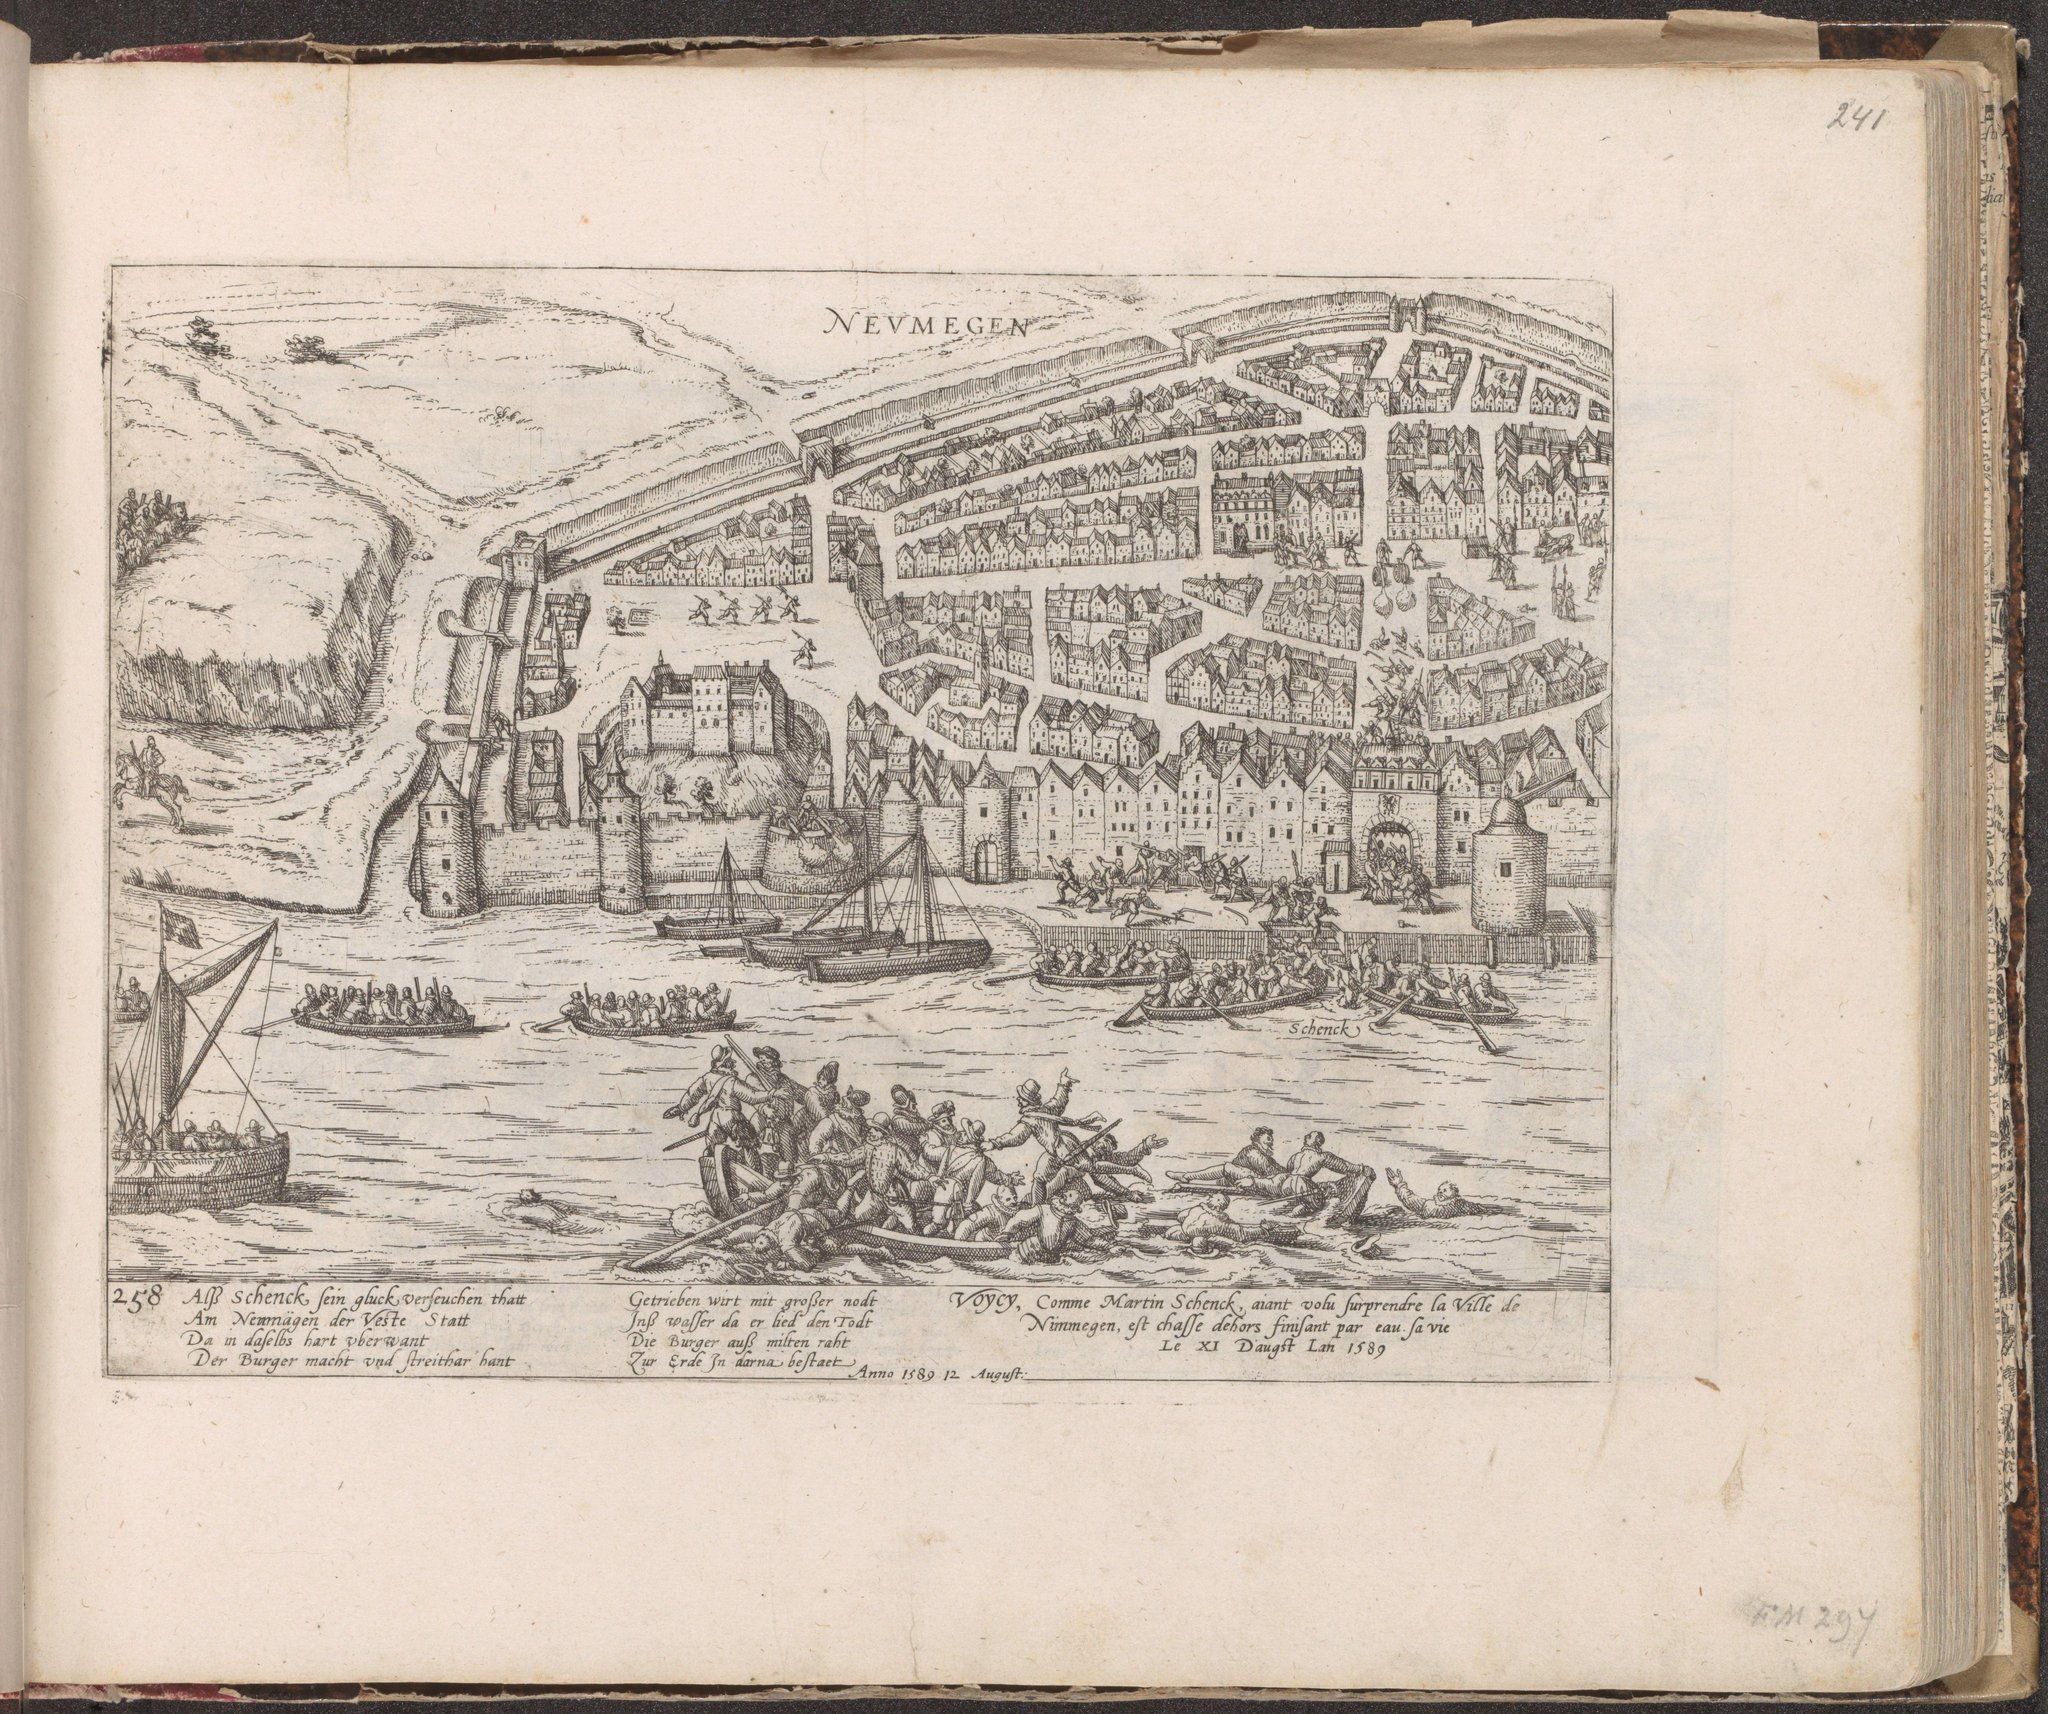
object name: print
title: Serie 10: Nederlandse en Buitenlandse Gebeurtenissen, 1587-1612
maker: frans hogenberg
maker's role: print maker, publisher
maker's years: 1538-1590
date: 1589-1591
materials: paper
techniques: etching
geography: cologne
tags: nijmegen, drowning, shipwrecked person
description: Mislukte aanval op Nijmegen, 10 augustus 1589. Martin Schenck verdrinkt in de Waal. Episode uit de Keulse Oorlog. Met onderschrift van 8 regels in het Duits en 3 regels in het Frans. Linksonder genummerd: 258. De prent maakt deel uit van een album.